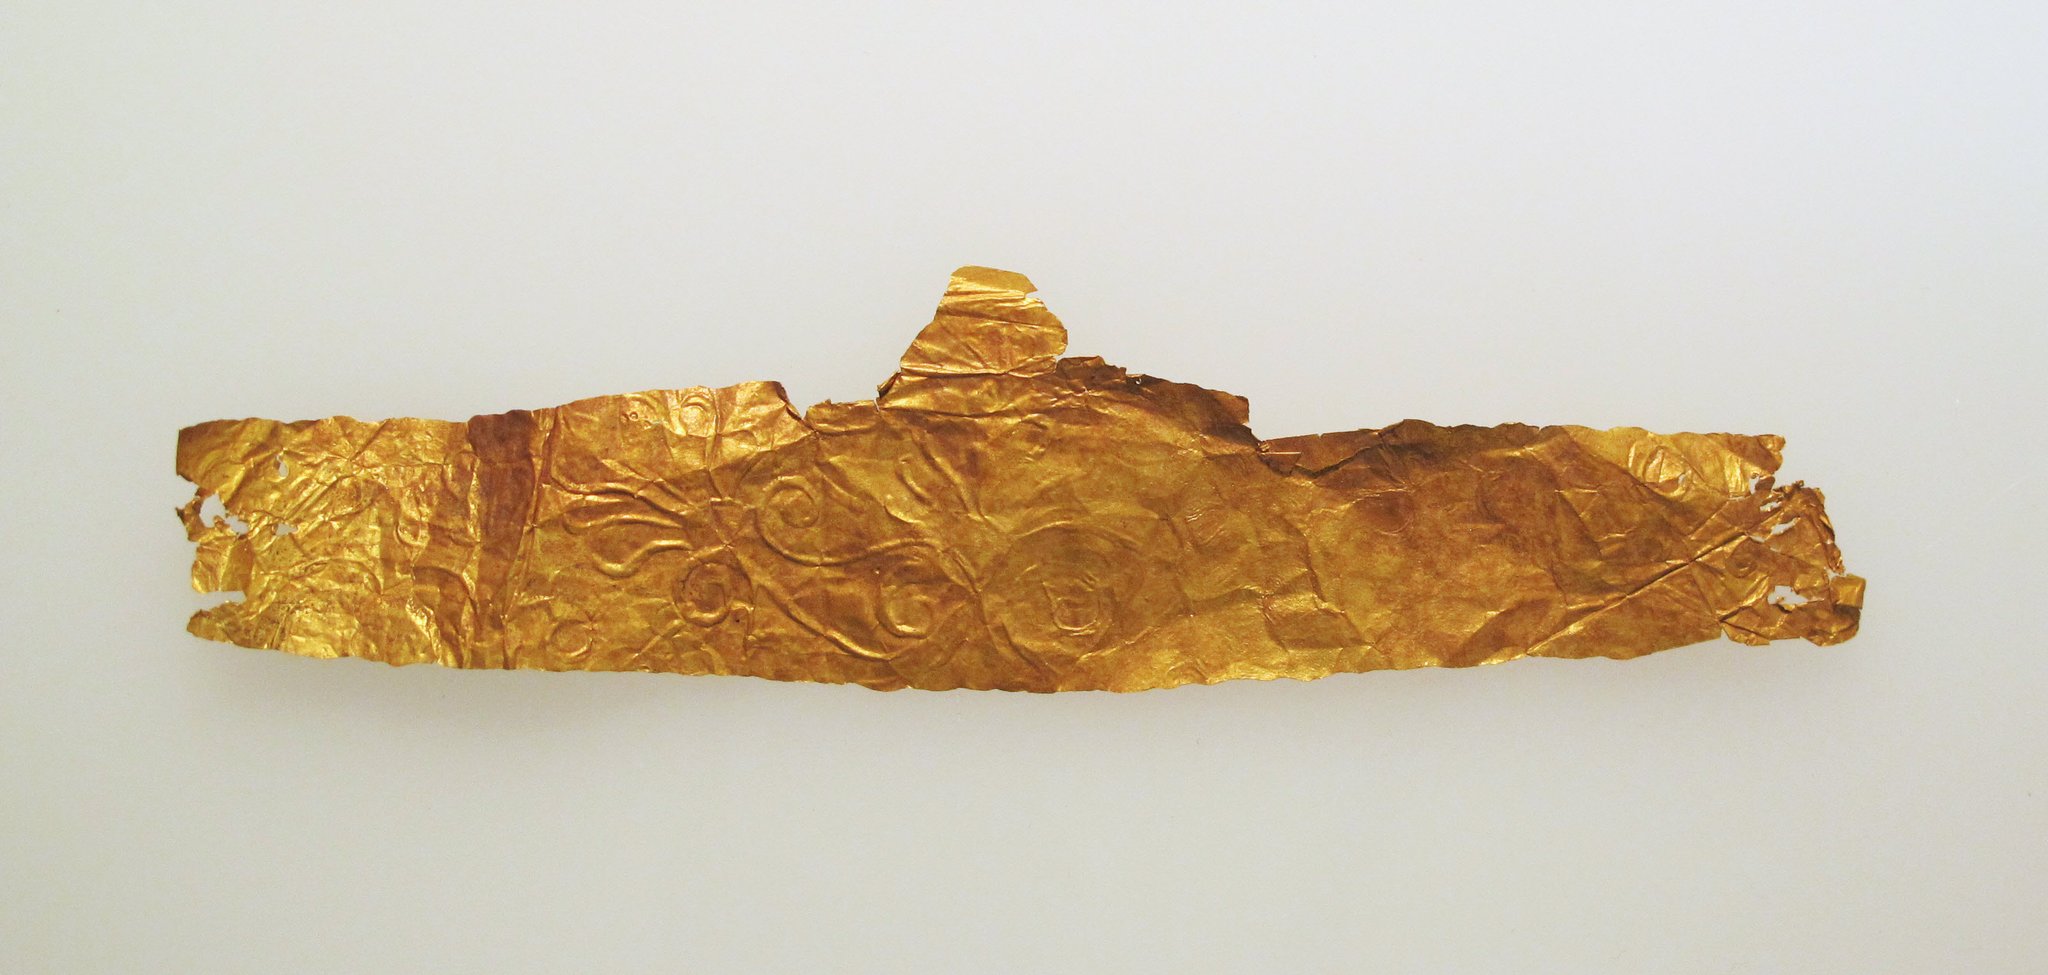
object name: frontlet of gold leaf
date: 7000 BCE-330 CE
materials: gold